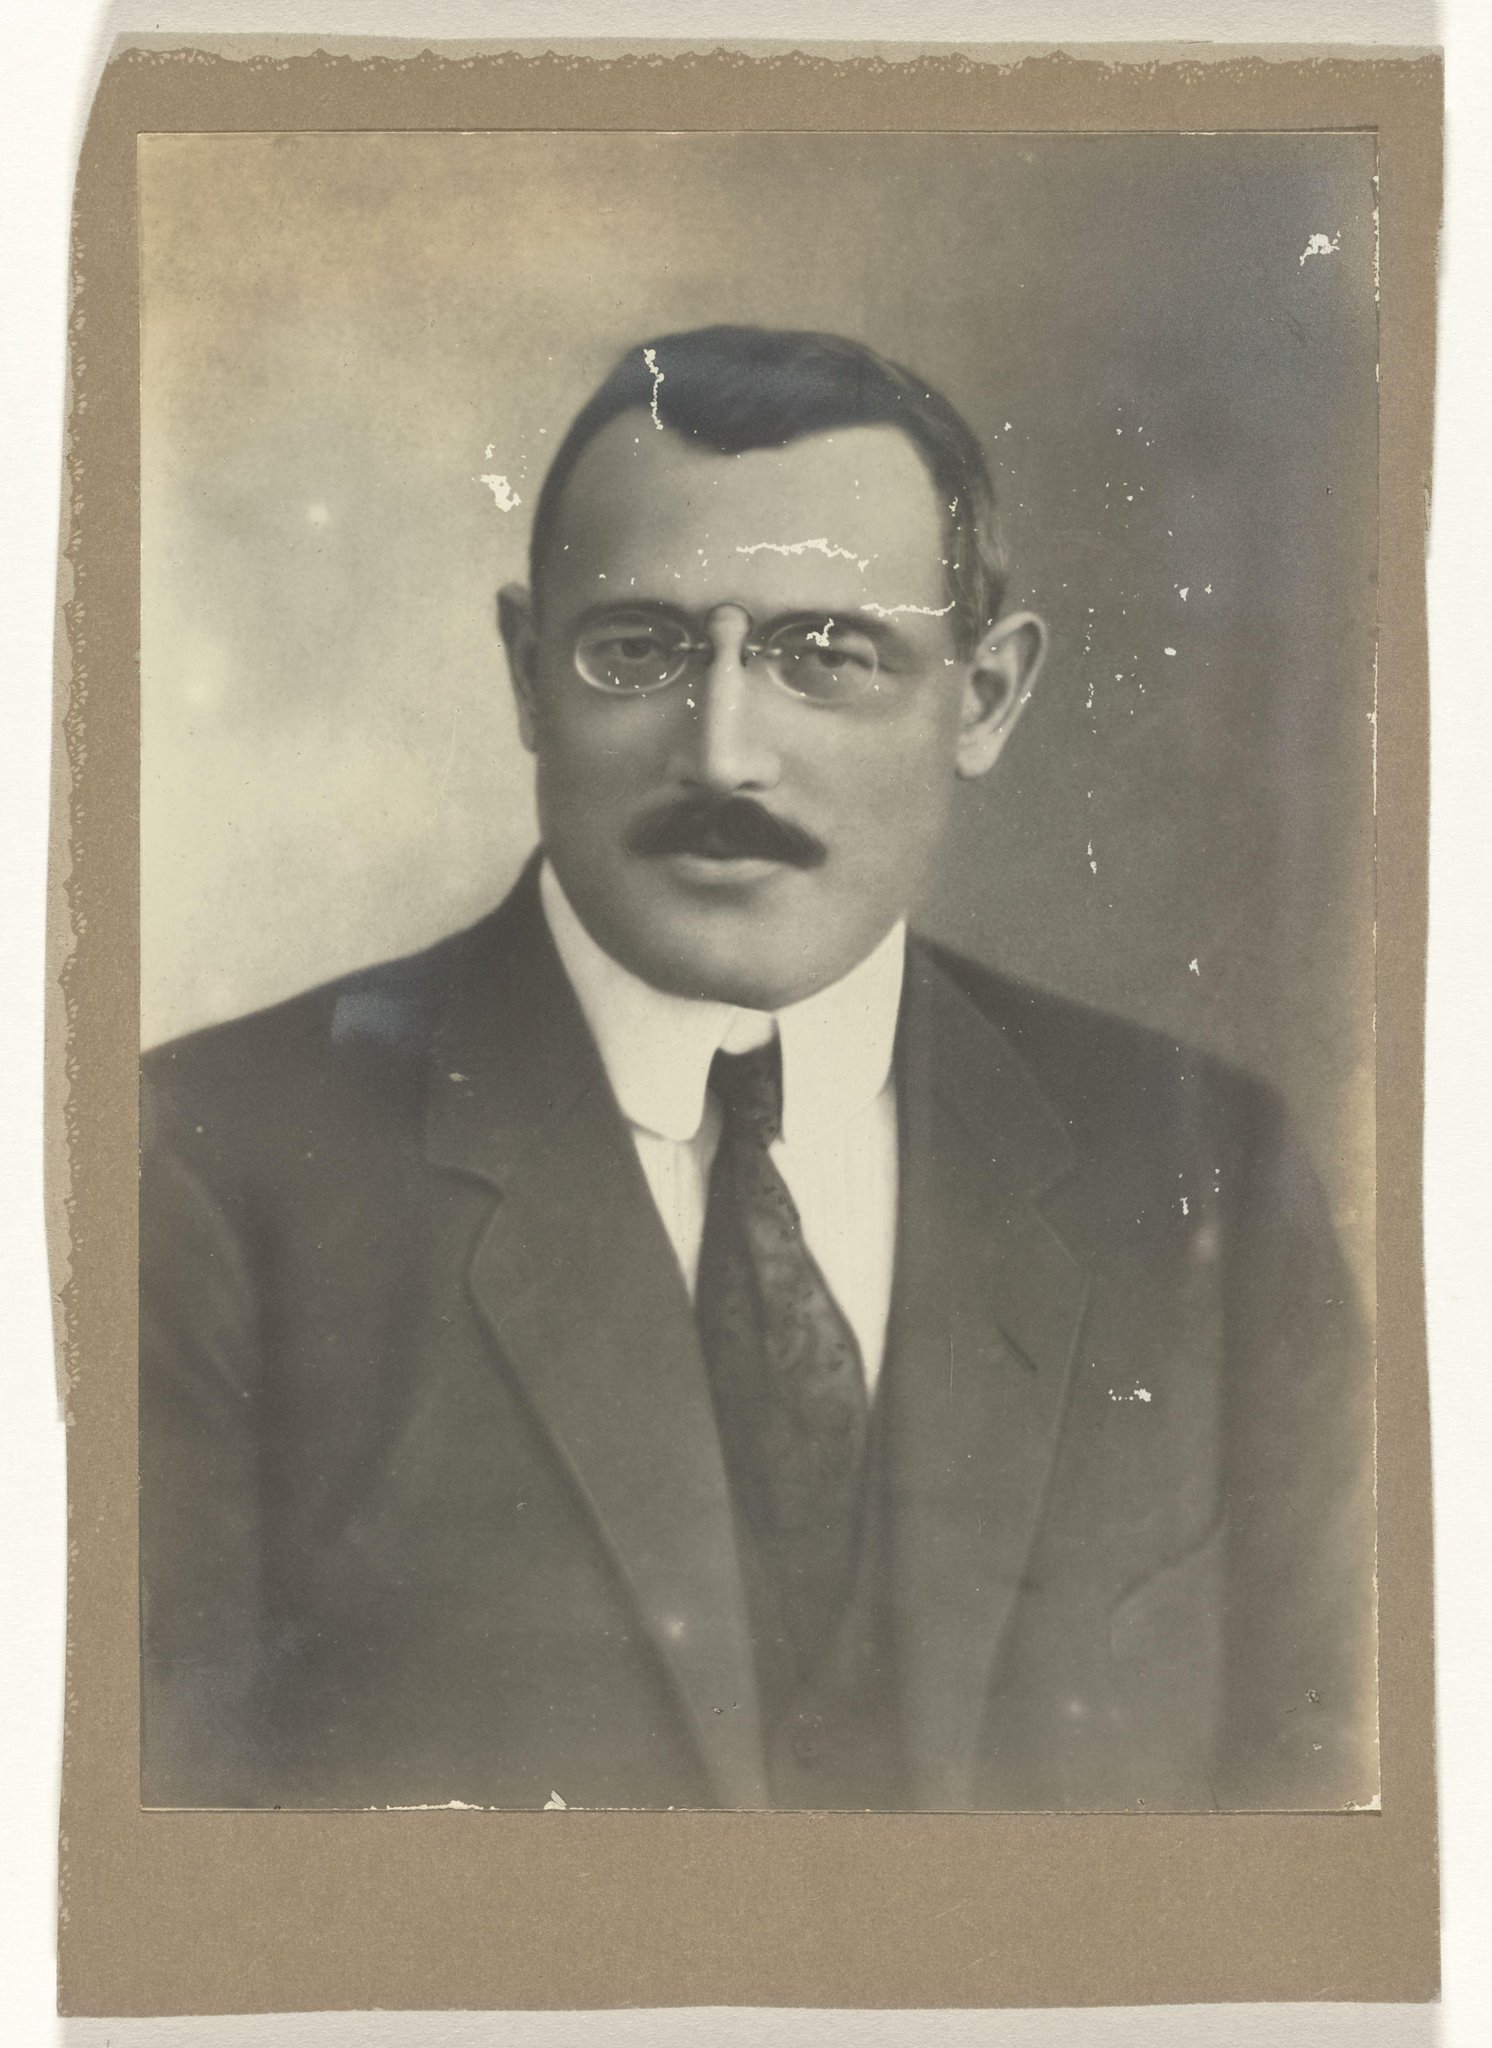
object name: photograph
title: Onbekende man met bril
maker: Anonymous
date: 1860-1910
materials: photographic support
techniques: gelatin silver print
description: Onbekende man met bril, snor, wit hemd, donkere stropdas en donkere jas.